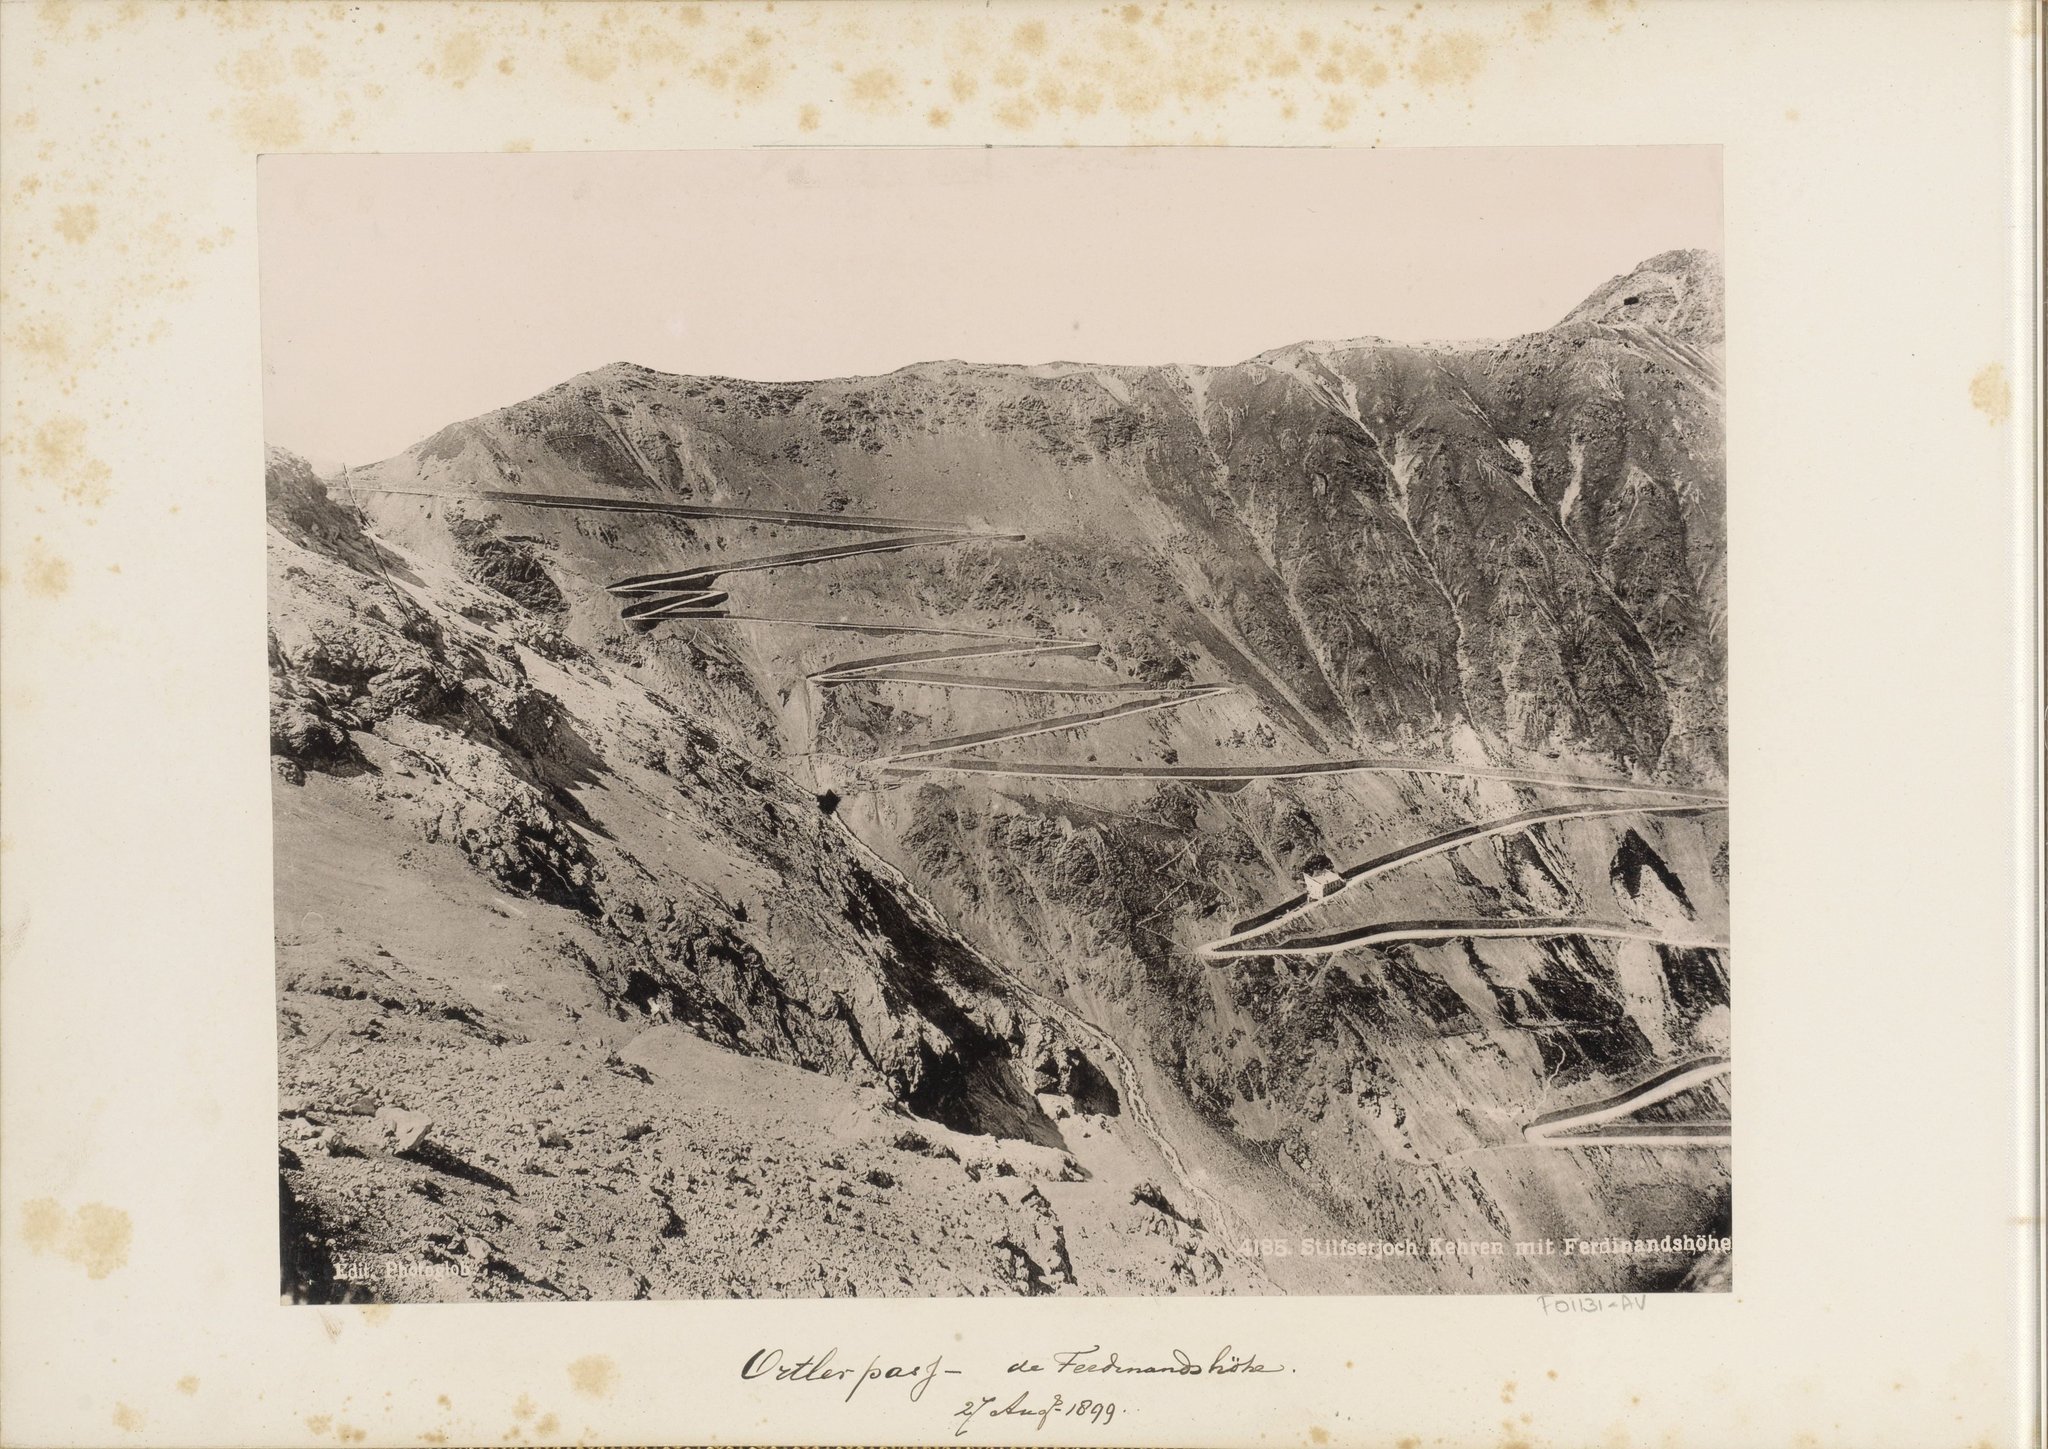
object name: album leaf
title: Gezicht op de Stelviopas en de uitspanning Ferdinandshöhe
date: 1880-1899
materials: paper, photographic support, ink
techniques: photograph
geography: tirol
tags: road, path, mountains (+ landscape with figures, staffage), hotel, hostelry, inn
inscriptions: number: ‘4185’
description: Onderdeel van Reisalbum met bezienswaardigheden in Duitsland, Oostenrijk, Zwitserland, Luxemburg en België.